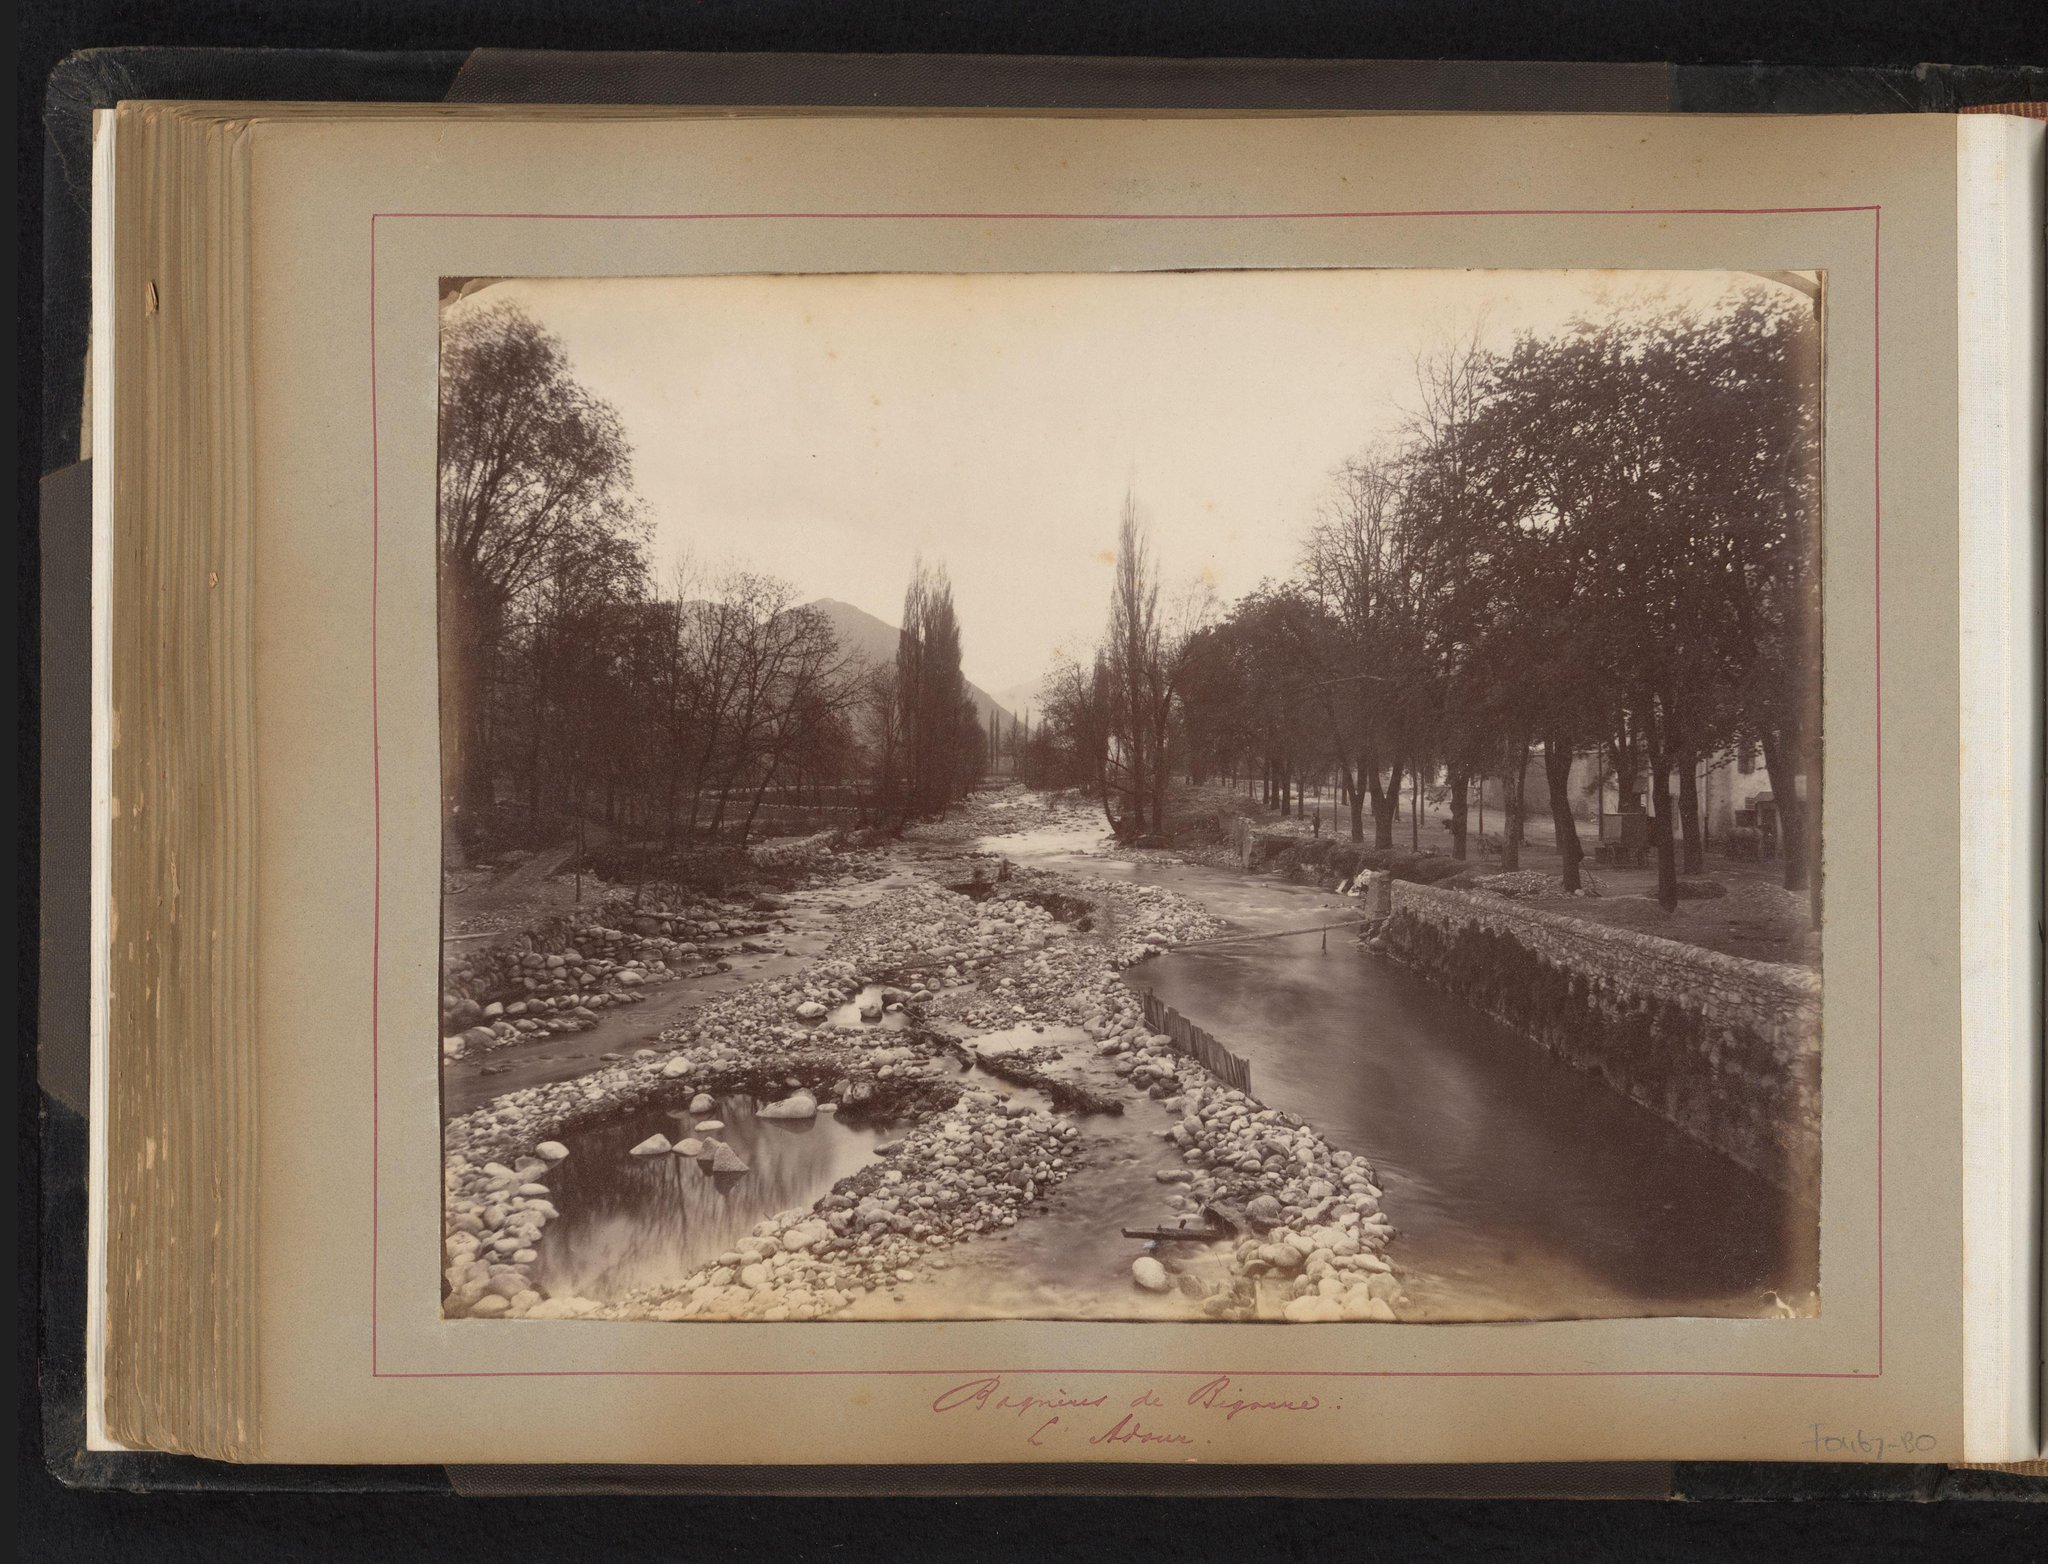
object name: album leaf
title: Landschap met een water in de omgeving van Bagnères-de-Bigorre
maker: Anonymous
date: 1880-1910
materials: photographic support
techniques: albumen print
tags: trees, landscapes with waters, waterscapes, seascapes (in the temperate zone)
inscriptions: annotation: ‘Bagnères-de-Bigorre/ [...]’